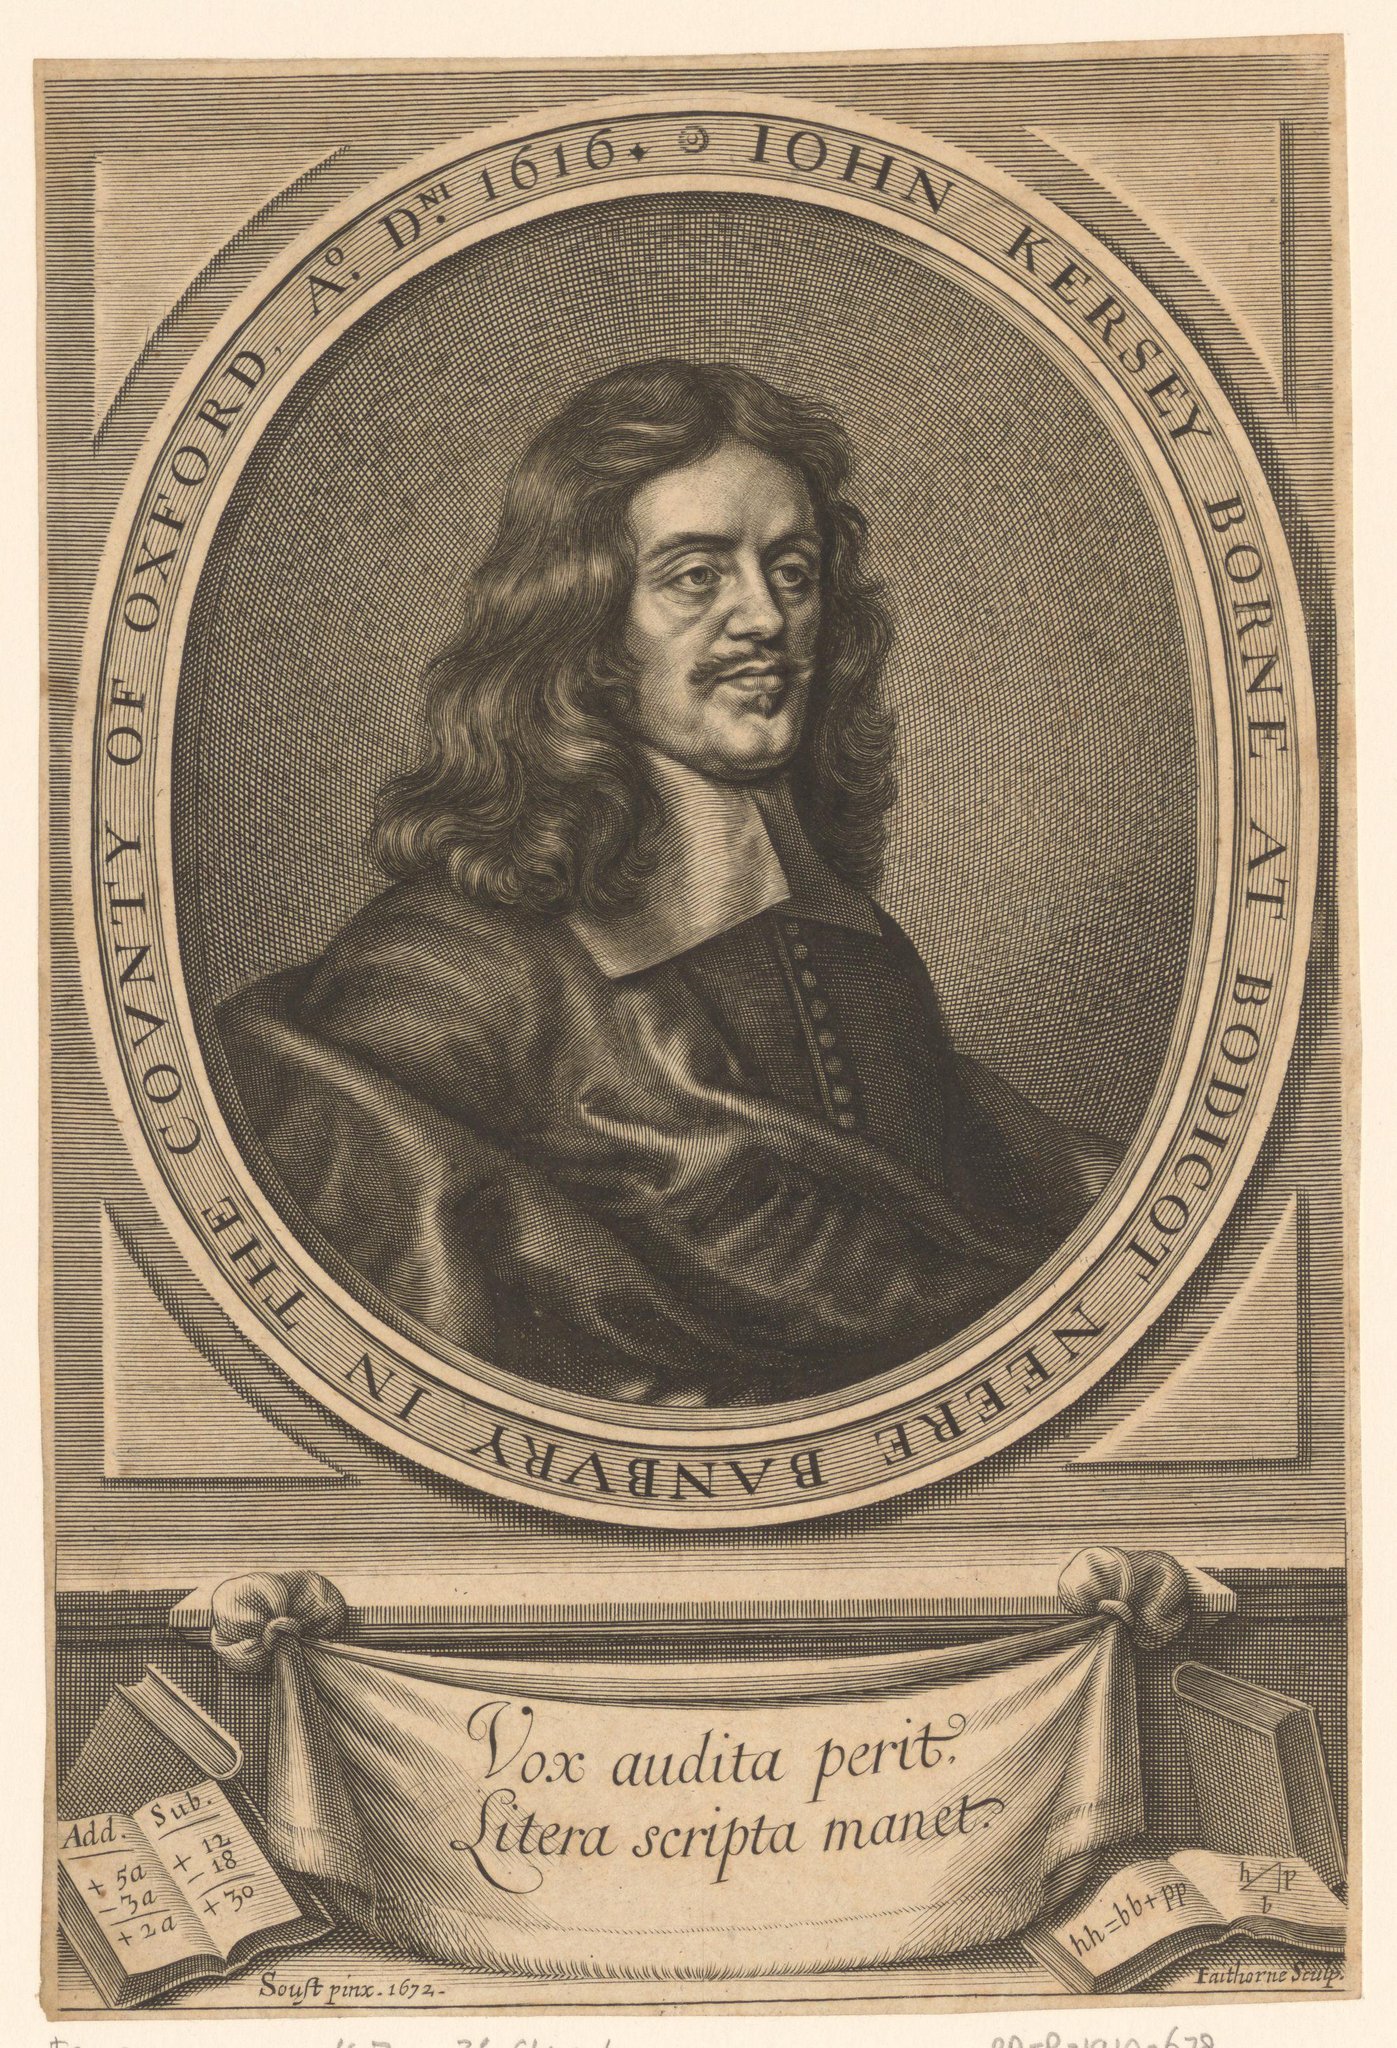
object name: book illustration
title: Portret van John Kersey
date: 1673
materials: paper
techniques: engraving, etching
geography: london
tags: historical persons, mathematics (+ portrait of scholar, scientist)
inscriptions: collector's mark: Lugt 2612, collector's mark: Lugt 2228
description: Prent uit: Kersey, John. Elements of that Mathematical Art Commonly Called Algebra. Londen: Thomas Passinger en Benjamin Hurlock, 1673.